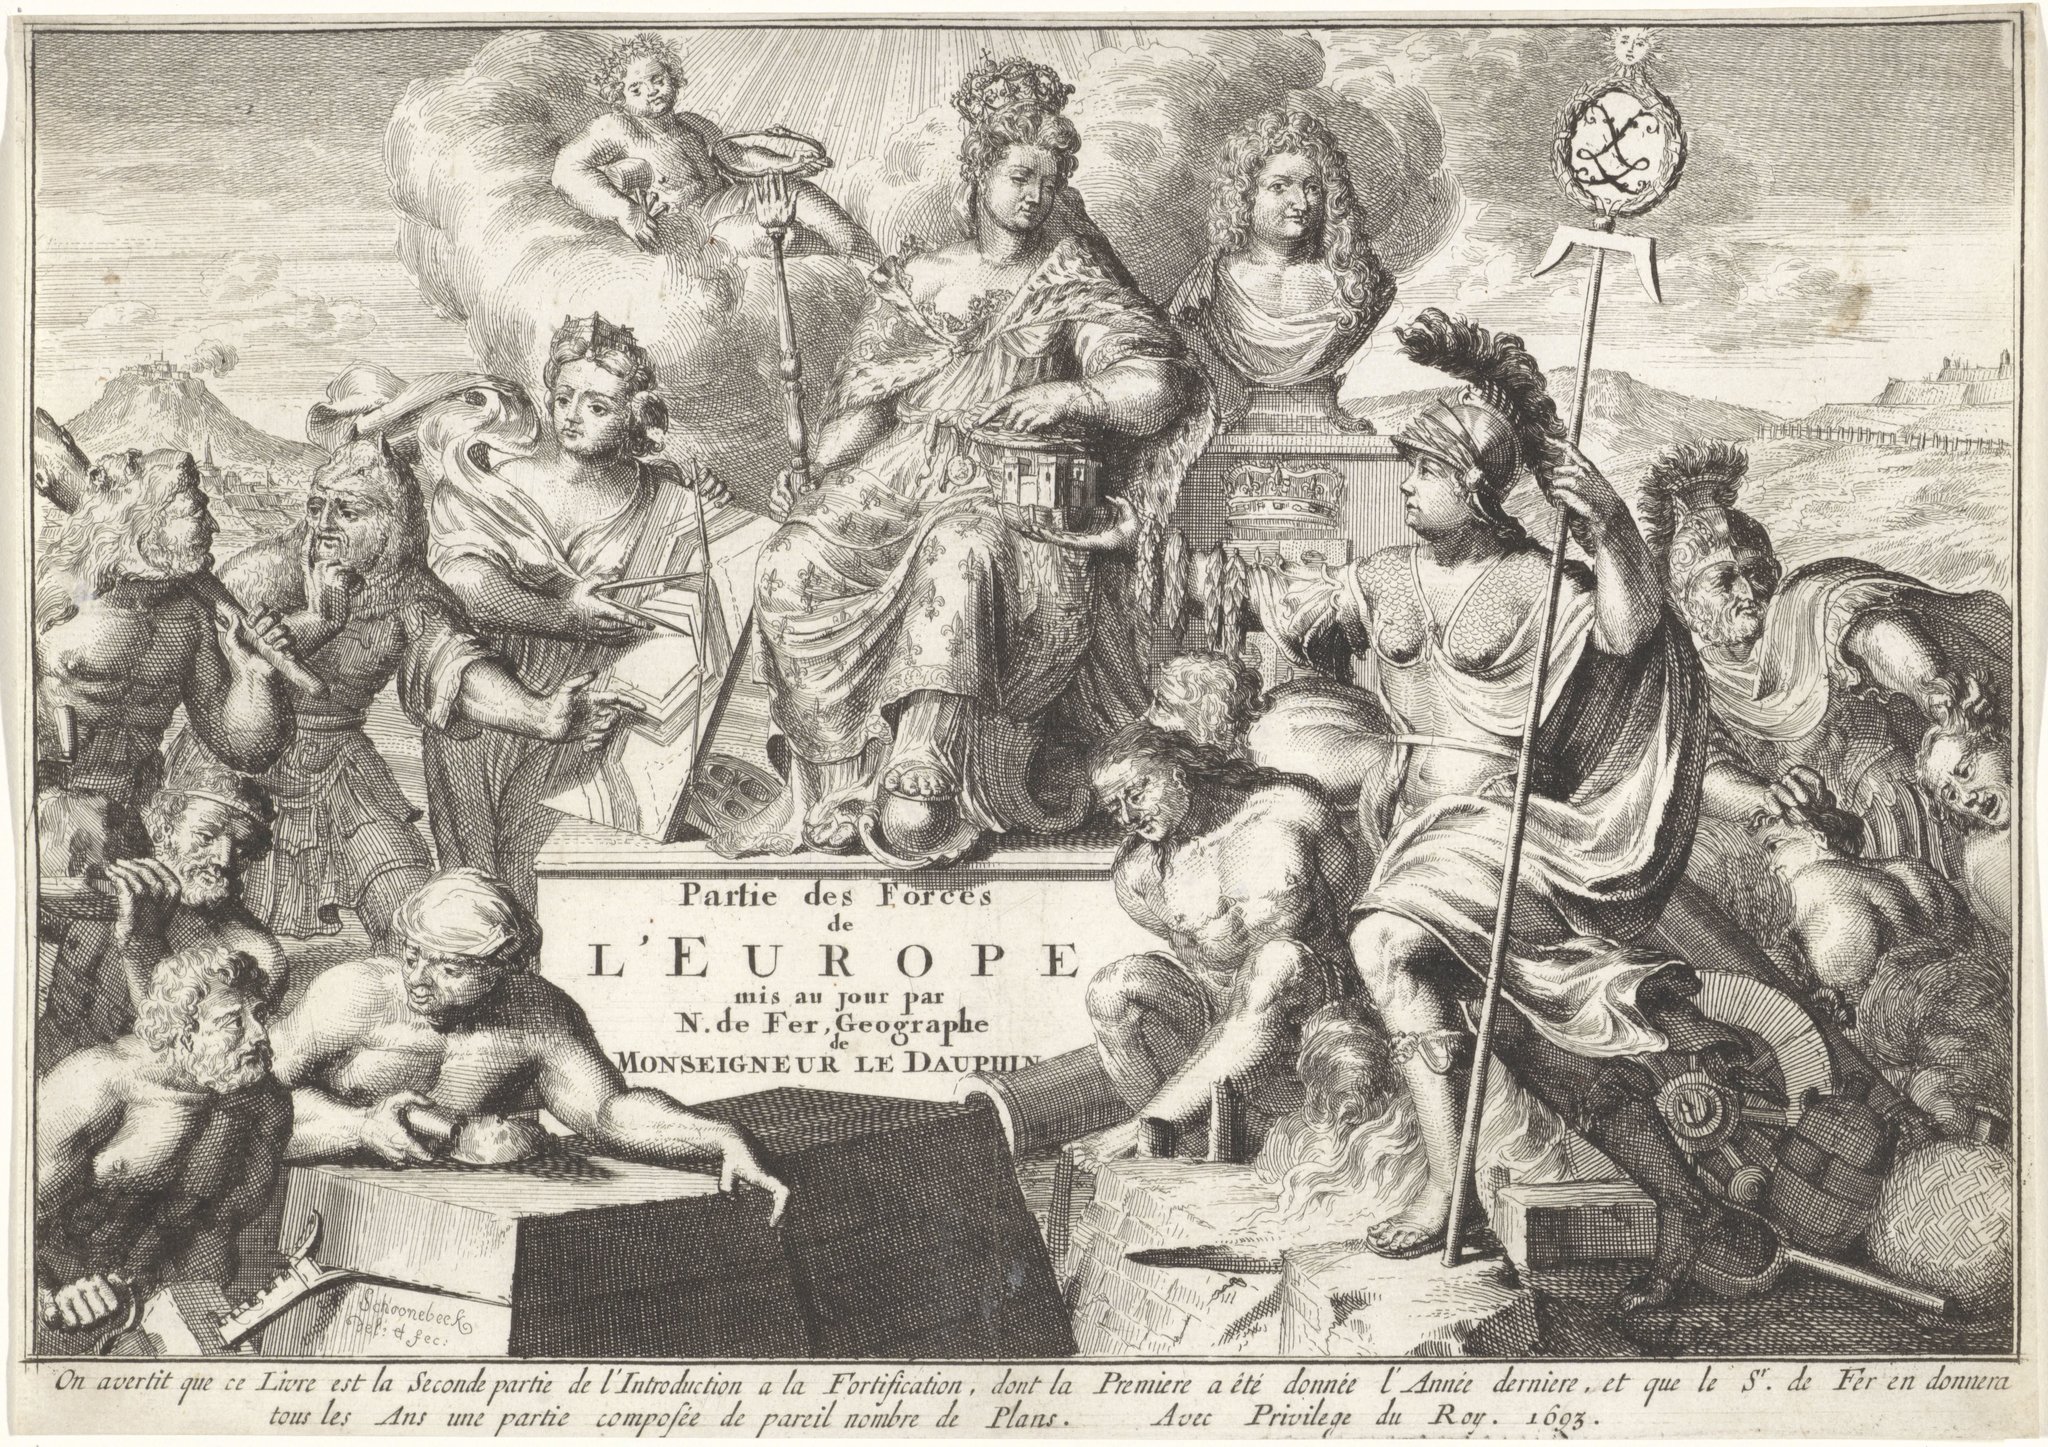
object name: titelblad, titelpagina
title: Allegorie op de overwinningen van het Franse leger in Europa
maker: adriaen schoonebeek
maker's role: print maker, publisher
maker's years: 1661-1705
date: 1693-1697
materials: paper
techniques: etching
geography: amsterdam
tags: title-page, symbols of particular nations, states, districts, etc., france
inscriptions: collector's mark: Lugt 2228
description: Gegraveerde titelpagina voor: Fer, Nicolas de. Les forces de l'Europe, ou description des principales villes, avec leurs fortifications : dessignées par les meilleurs ingenieurs, particulierement celles [...] de la France, dont les plans ont esté levez par M. de Vauban. Parijs: 1693-1697.